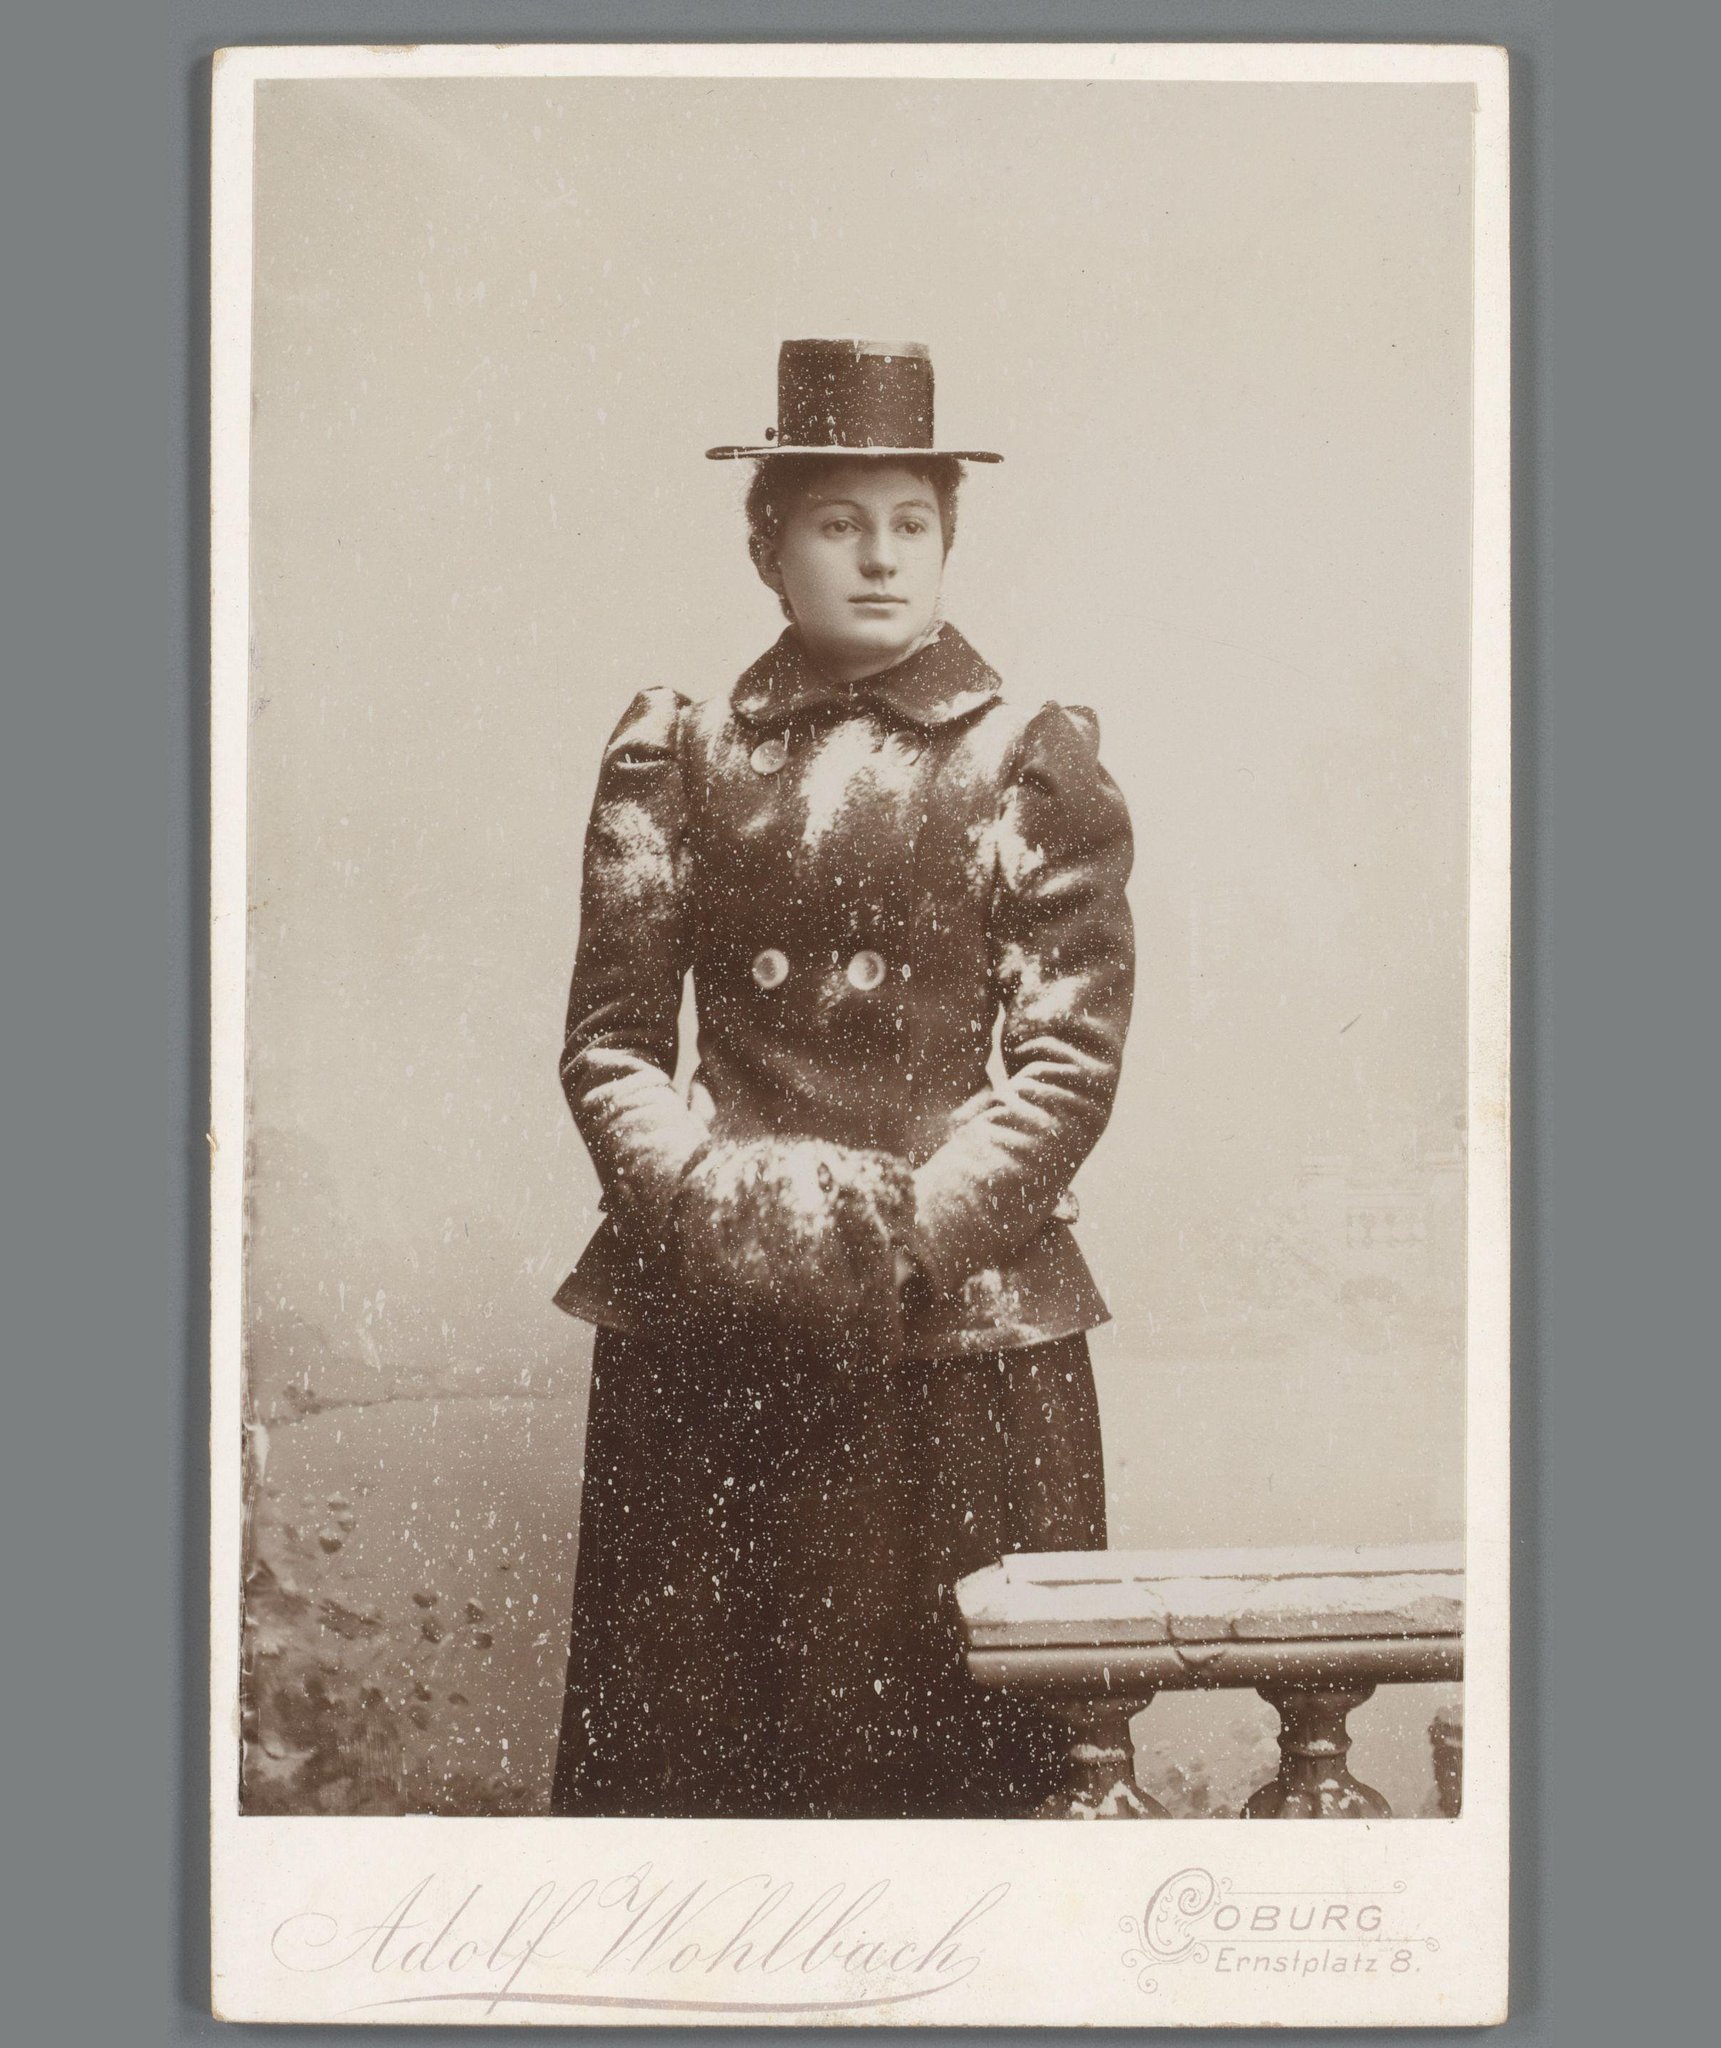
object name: cabinet photograph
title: Portret van een onbekende vrouw met hoed en mof, in de sneeuw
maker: adolf wohlbach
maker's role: fotograaf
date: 1898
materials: paper, cardboard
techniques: gelatin silver print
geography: coburg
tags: muff, historical persons not known by name - bb - woman, snow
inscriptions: inscription: ‘Adolf Wohlbach/ Coburg/ Ernstplatz 8’, inscription: ‘Adolf Wohlbach/ Photographisches Atelier/ Coburg, Ernst-Platz 8/ Vergrösserungen nach jedem Bilde/ auf allen modernen Papieren./ Die Platte bleibt für Nachbestellungen aufbewahrt./ Chr. Harbers, Leipzig.’